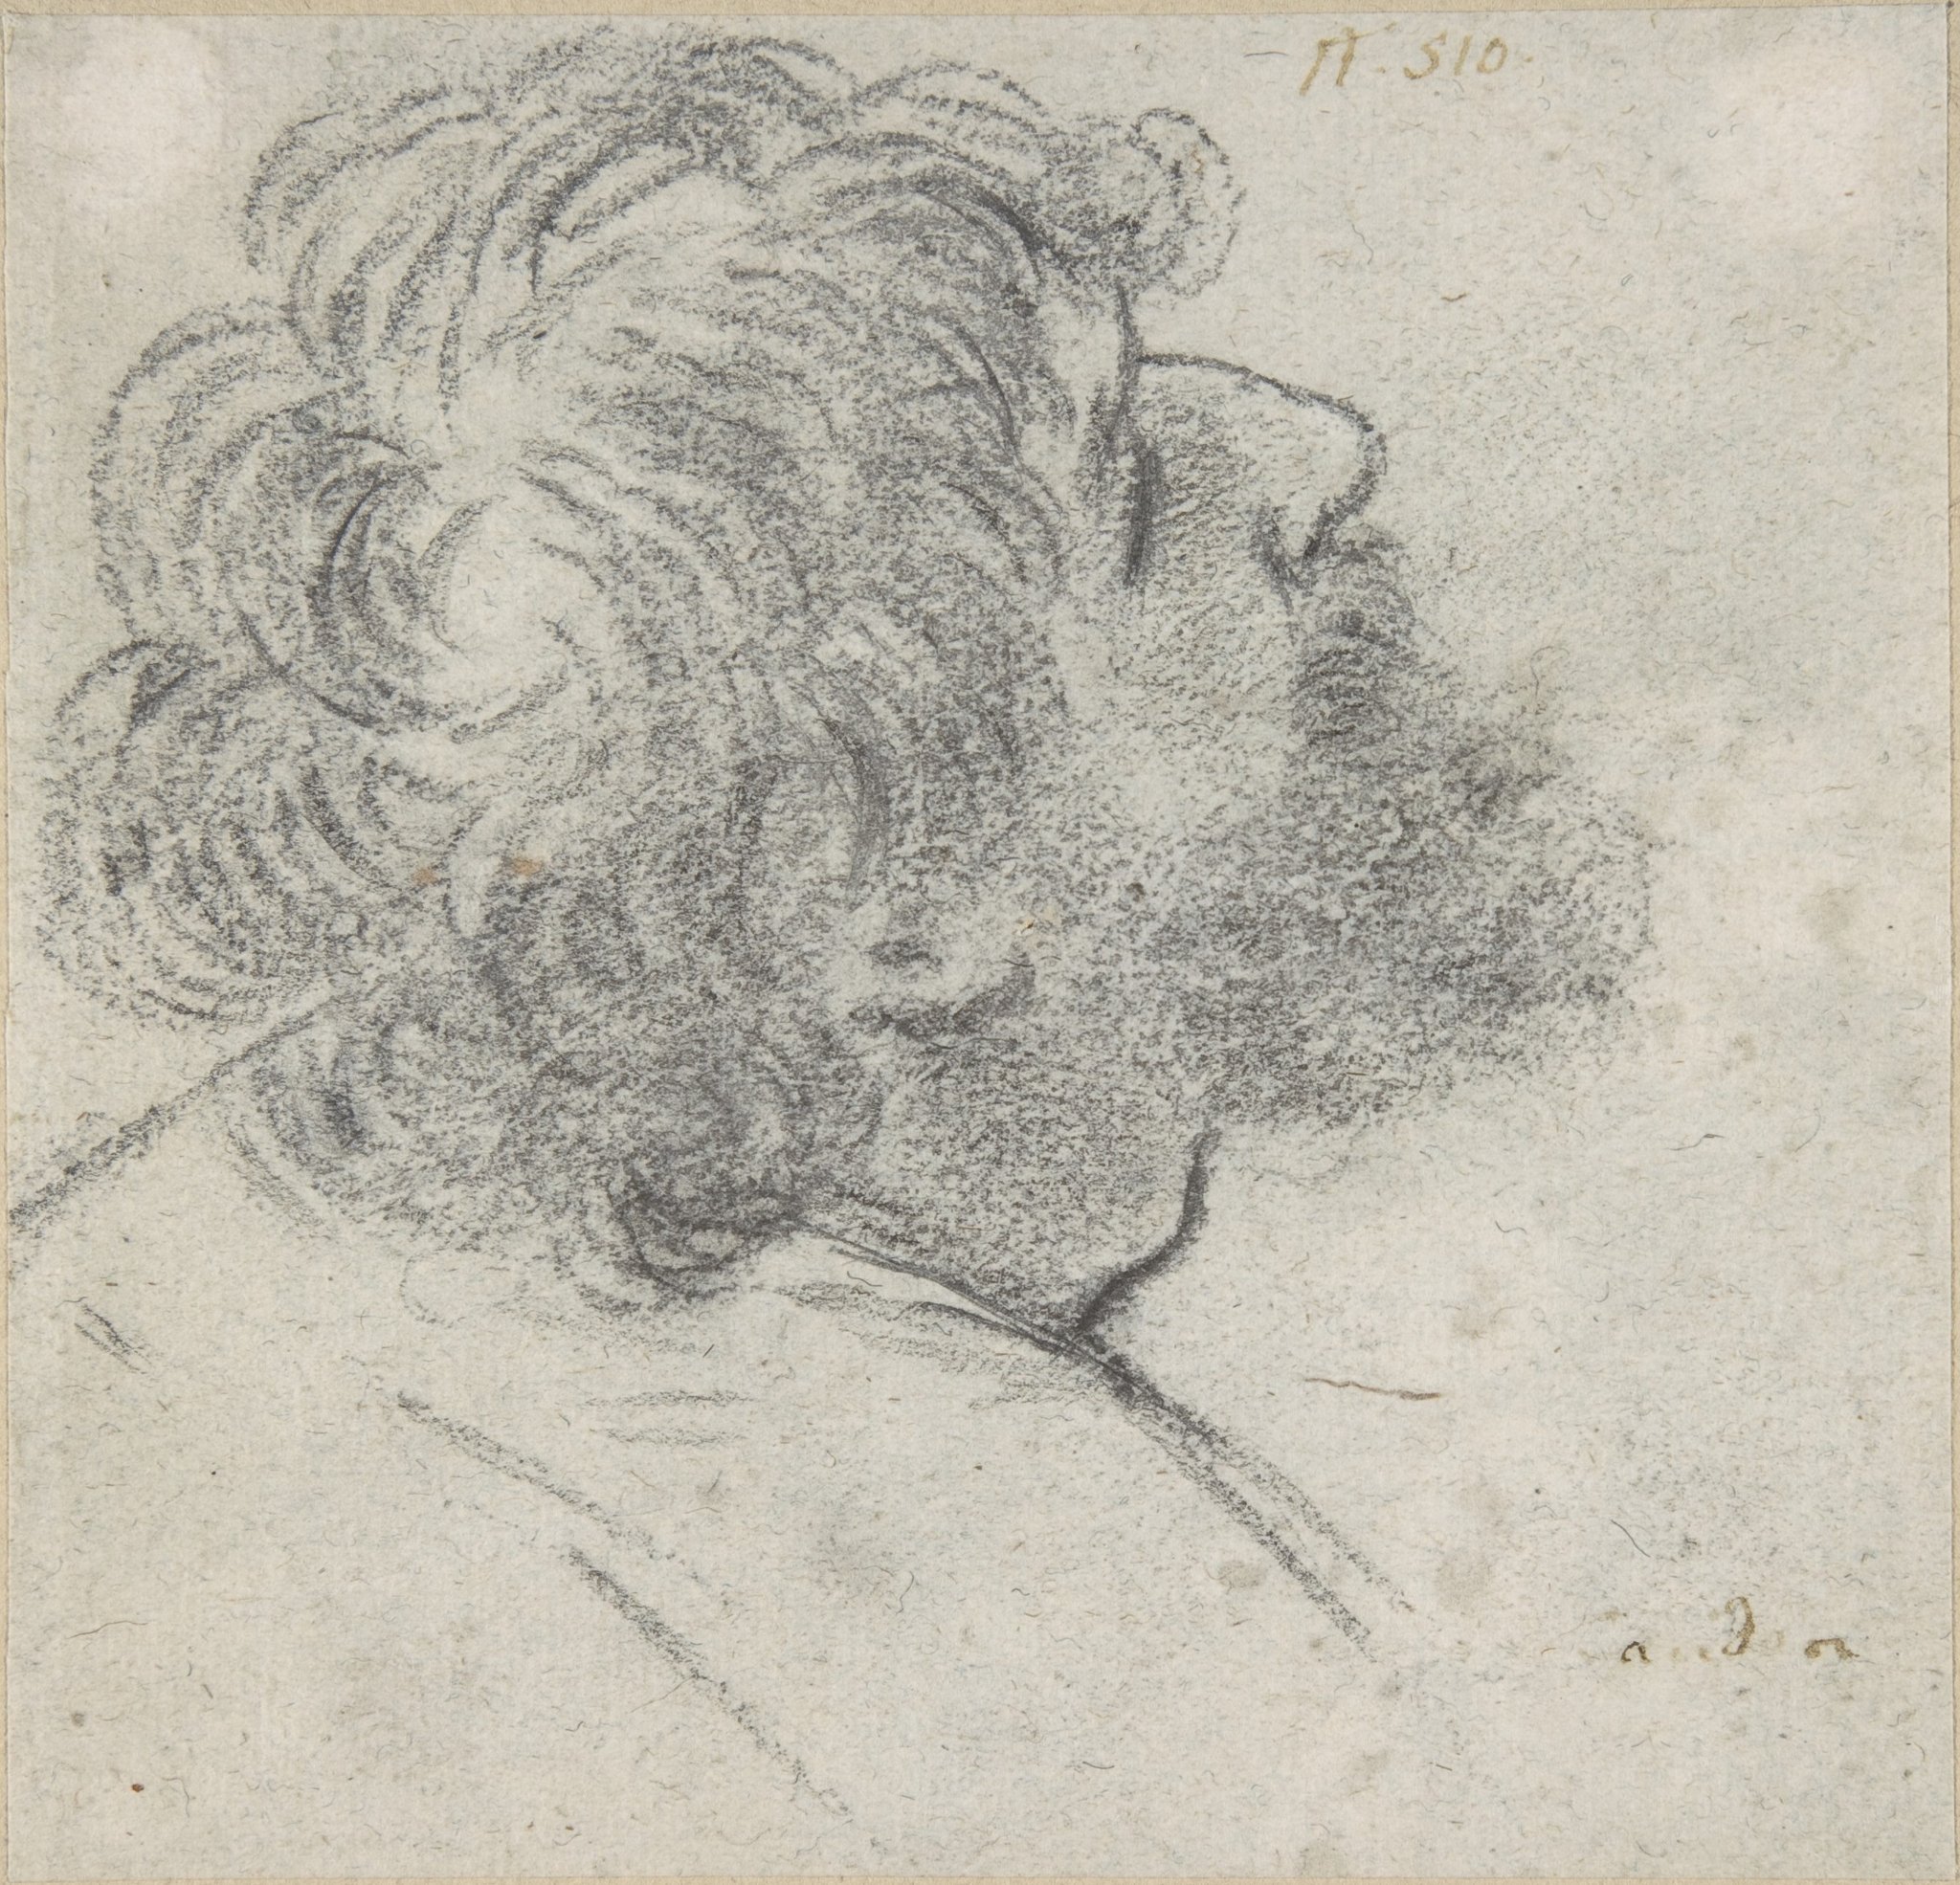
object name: drawing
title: Head of a Bearded Man Looking to Upper Right (recto); Head of an Old Man and a Drapery Study (verso)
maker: giacomo cavedone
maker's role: artist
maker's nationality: italian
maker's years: 1577-1660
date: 1577-1660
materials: chalk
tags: heads,men